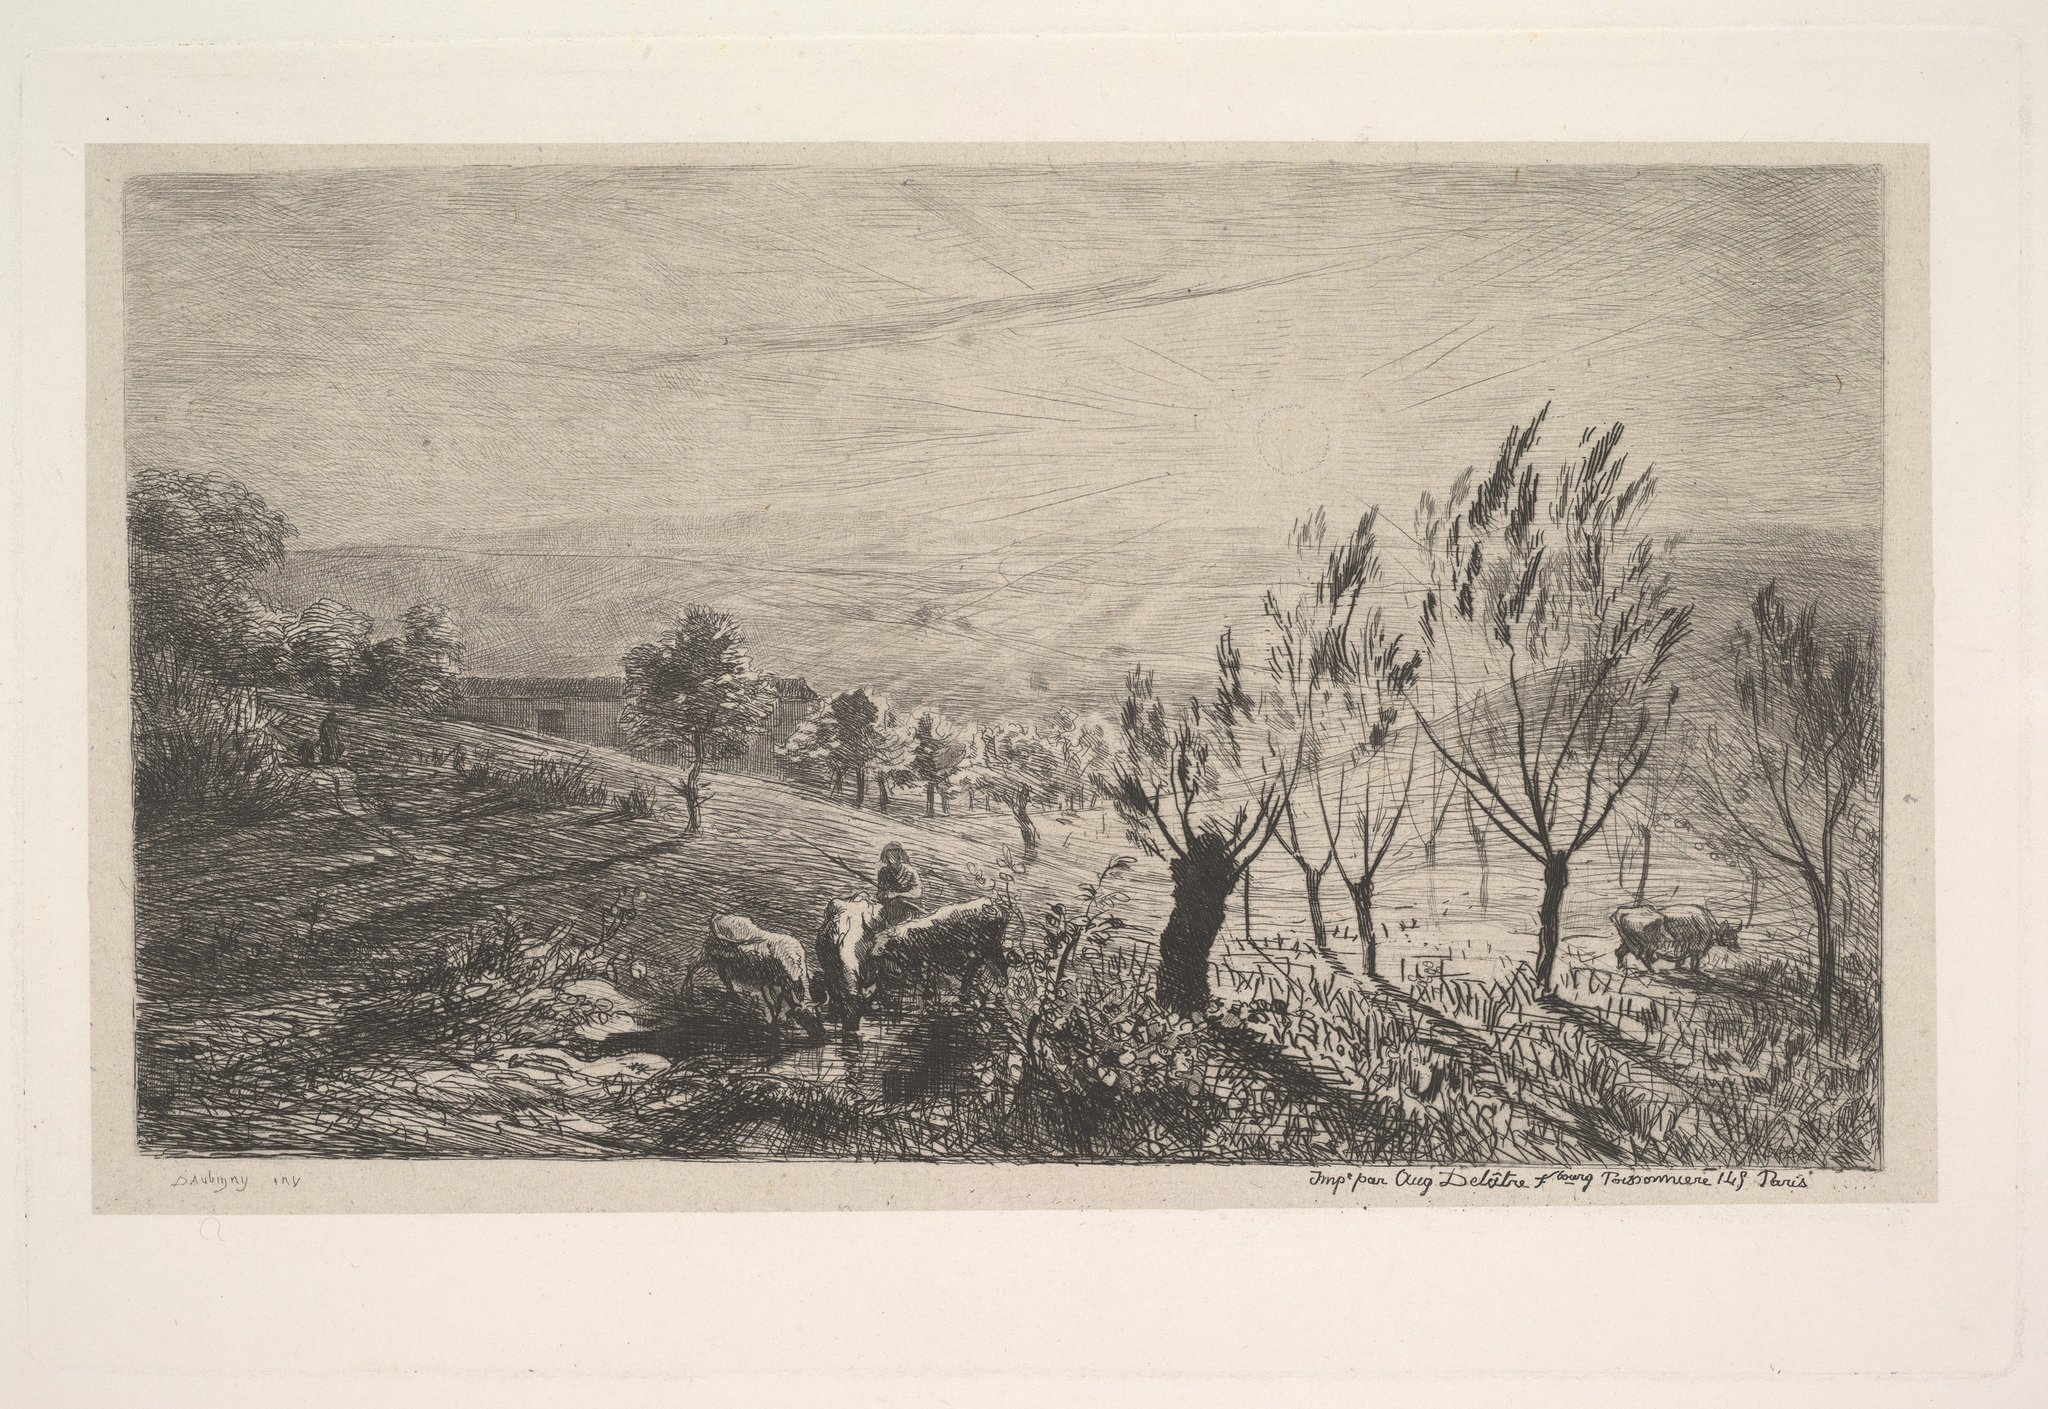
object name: print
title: Sunrise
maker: charles-françois daubigny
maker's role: artist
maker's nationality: french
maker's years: 1817-1878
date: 1850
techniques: printmaking, etching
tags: animals,sun,landscapes,dawn